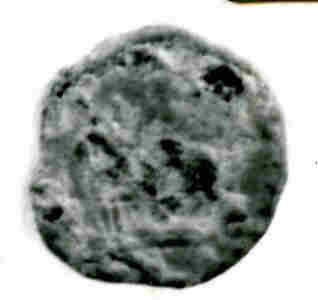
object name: coin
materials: copper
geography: al-muhammadiyeh